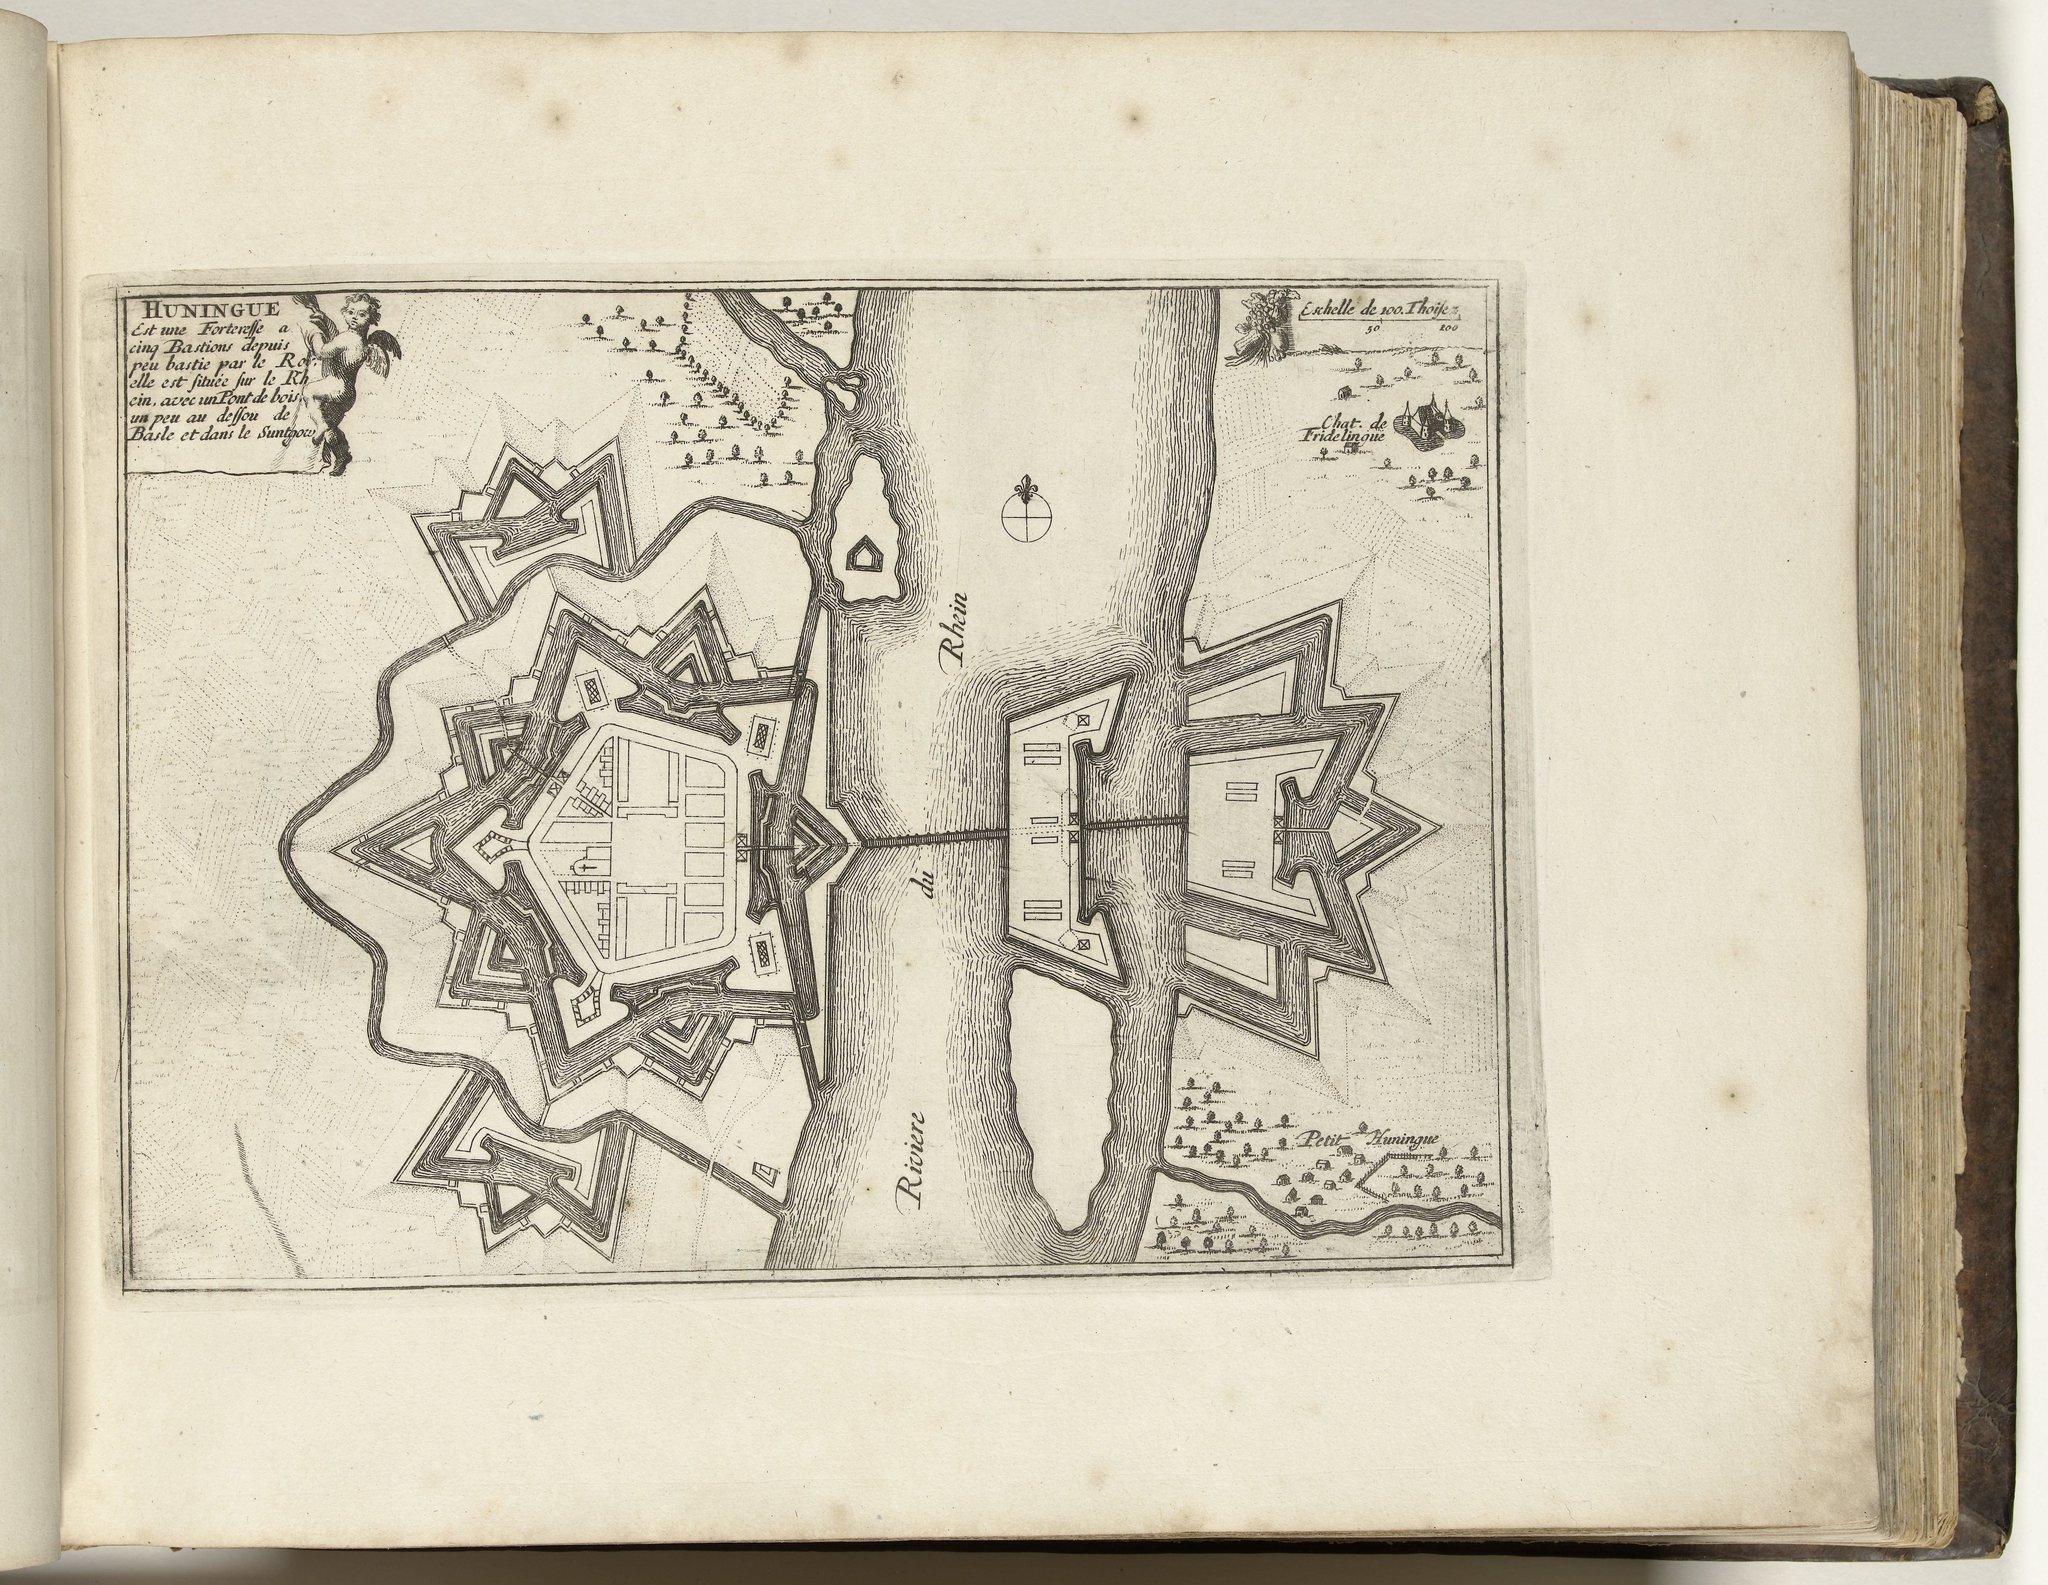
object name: print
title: Huningue Est une Fortresse (...) un peu dessou de Basle (...)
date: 1693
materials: paper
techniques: etching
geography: france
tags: fortress, maps of cities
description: Plattegrond van de versterkingen om de Franse stad Huningue. Onderdeel van het tweede deel (1693) van het prentwerk waarin gebundeld zijn de acht delen van Les forces de l'Europe uitgegeven tussen 1693-1697. Het prentwerk bestaat uit 175 platen met plannen (afkomstig van Sébastien Le Prestre, Seigneur de Vauban) van vermaarde sterke steden en vestingen in de Negenjarige Oorlog. Titel en opschriften in het Frans.